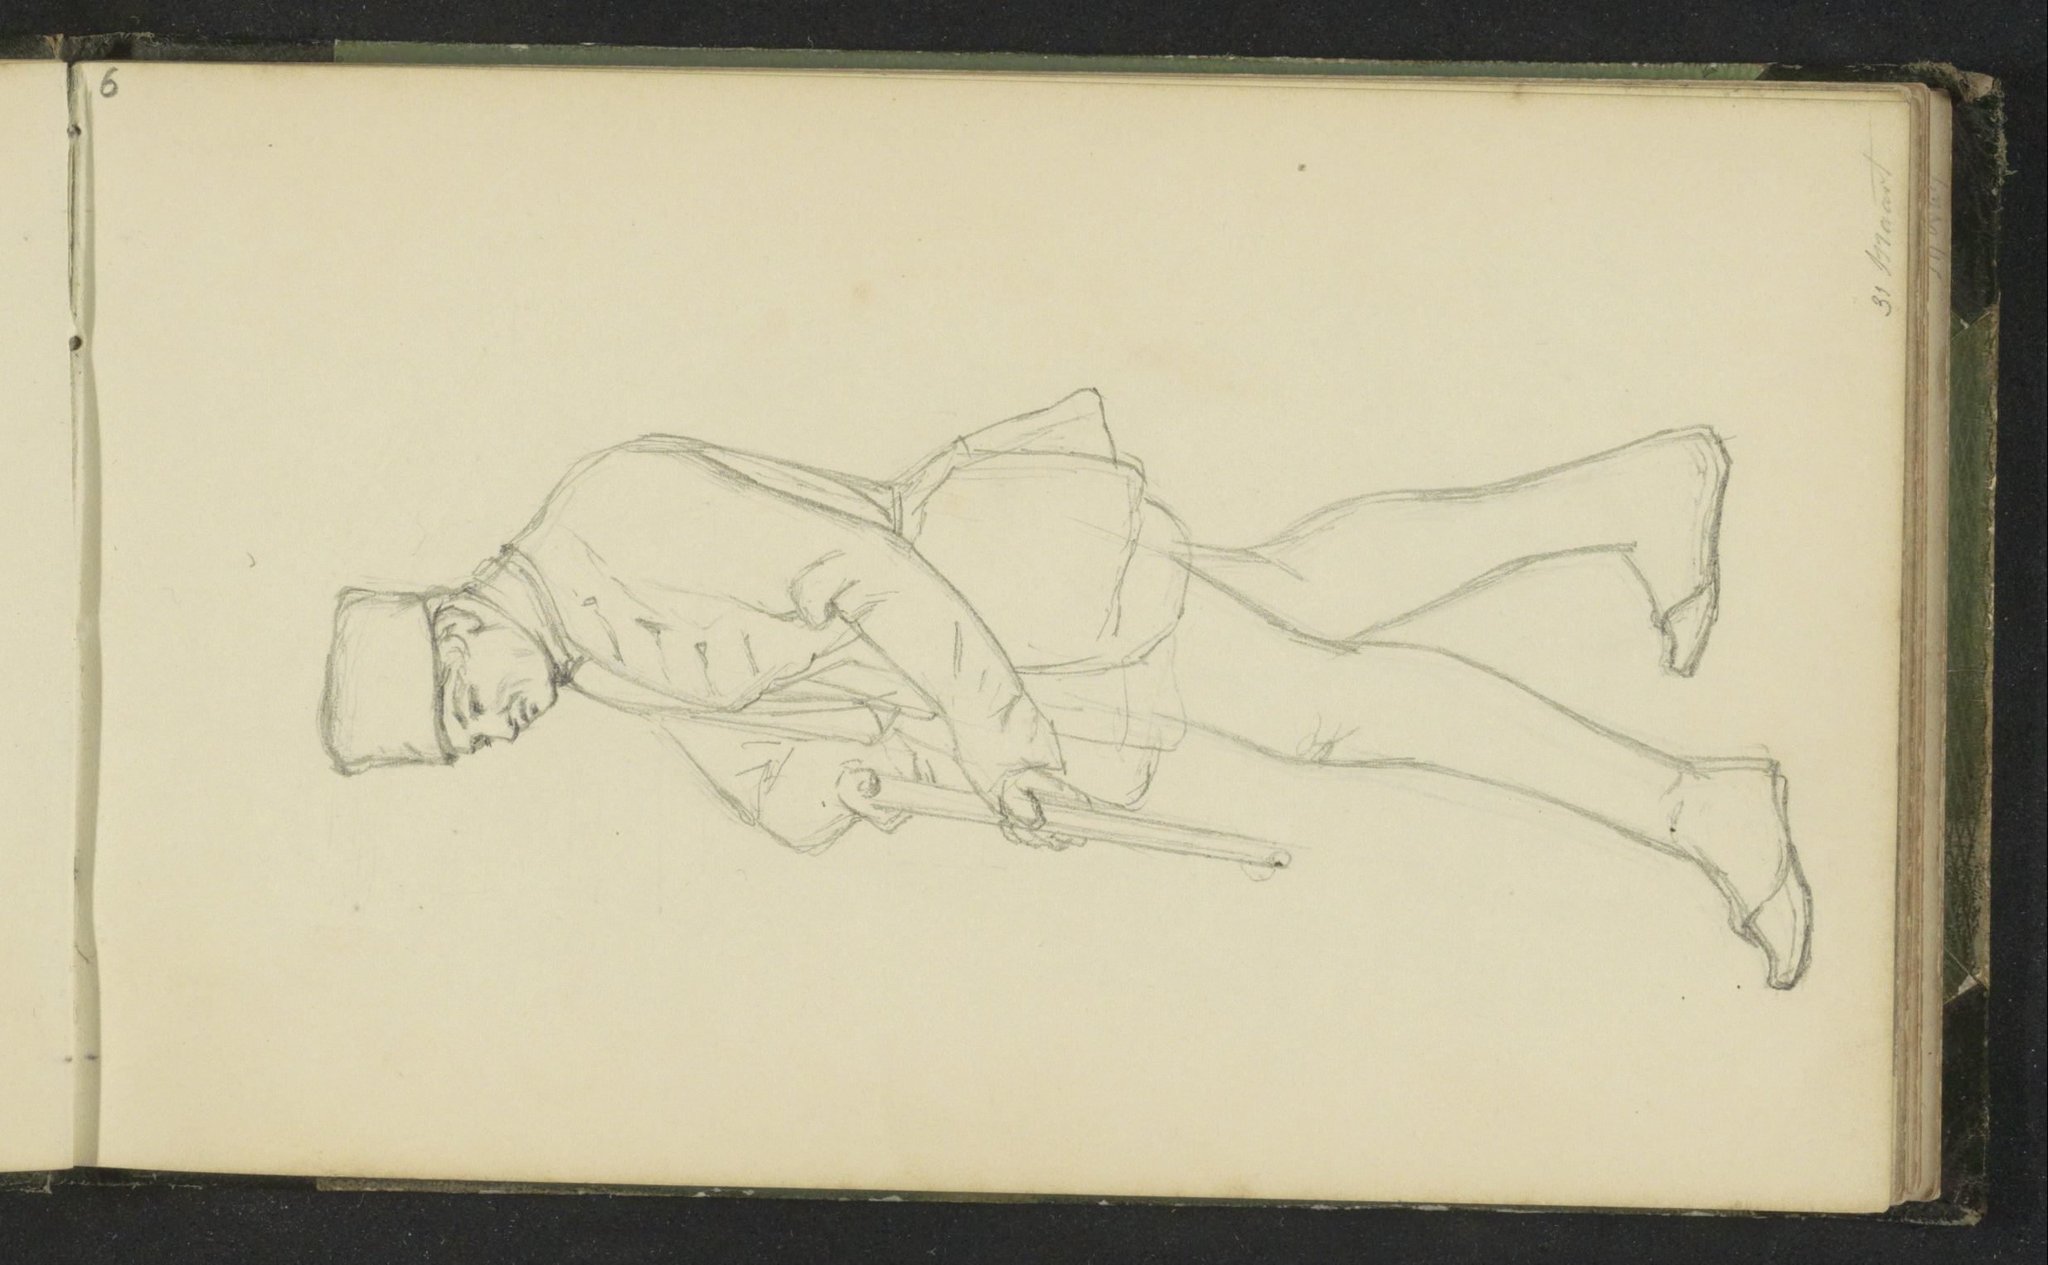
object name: sketchbook leaf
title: Soldaat met een wapen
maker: hendrik abraham klinkhamer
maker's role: draughtsman, painter, print maker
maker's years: 1810-1872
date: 1803-1843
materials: paper, pencil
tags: weapons, the soldier; the soldier's life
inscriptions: date: ‘31 Maart’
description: Mogelijk draagt de man een geweer of zwaard. Blad 6 recto uit een schetsboek met 40 bladen.